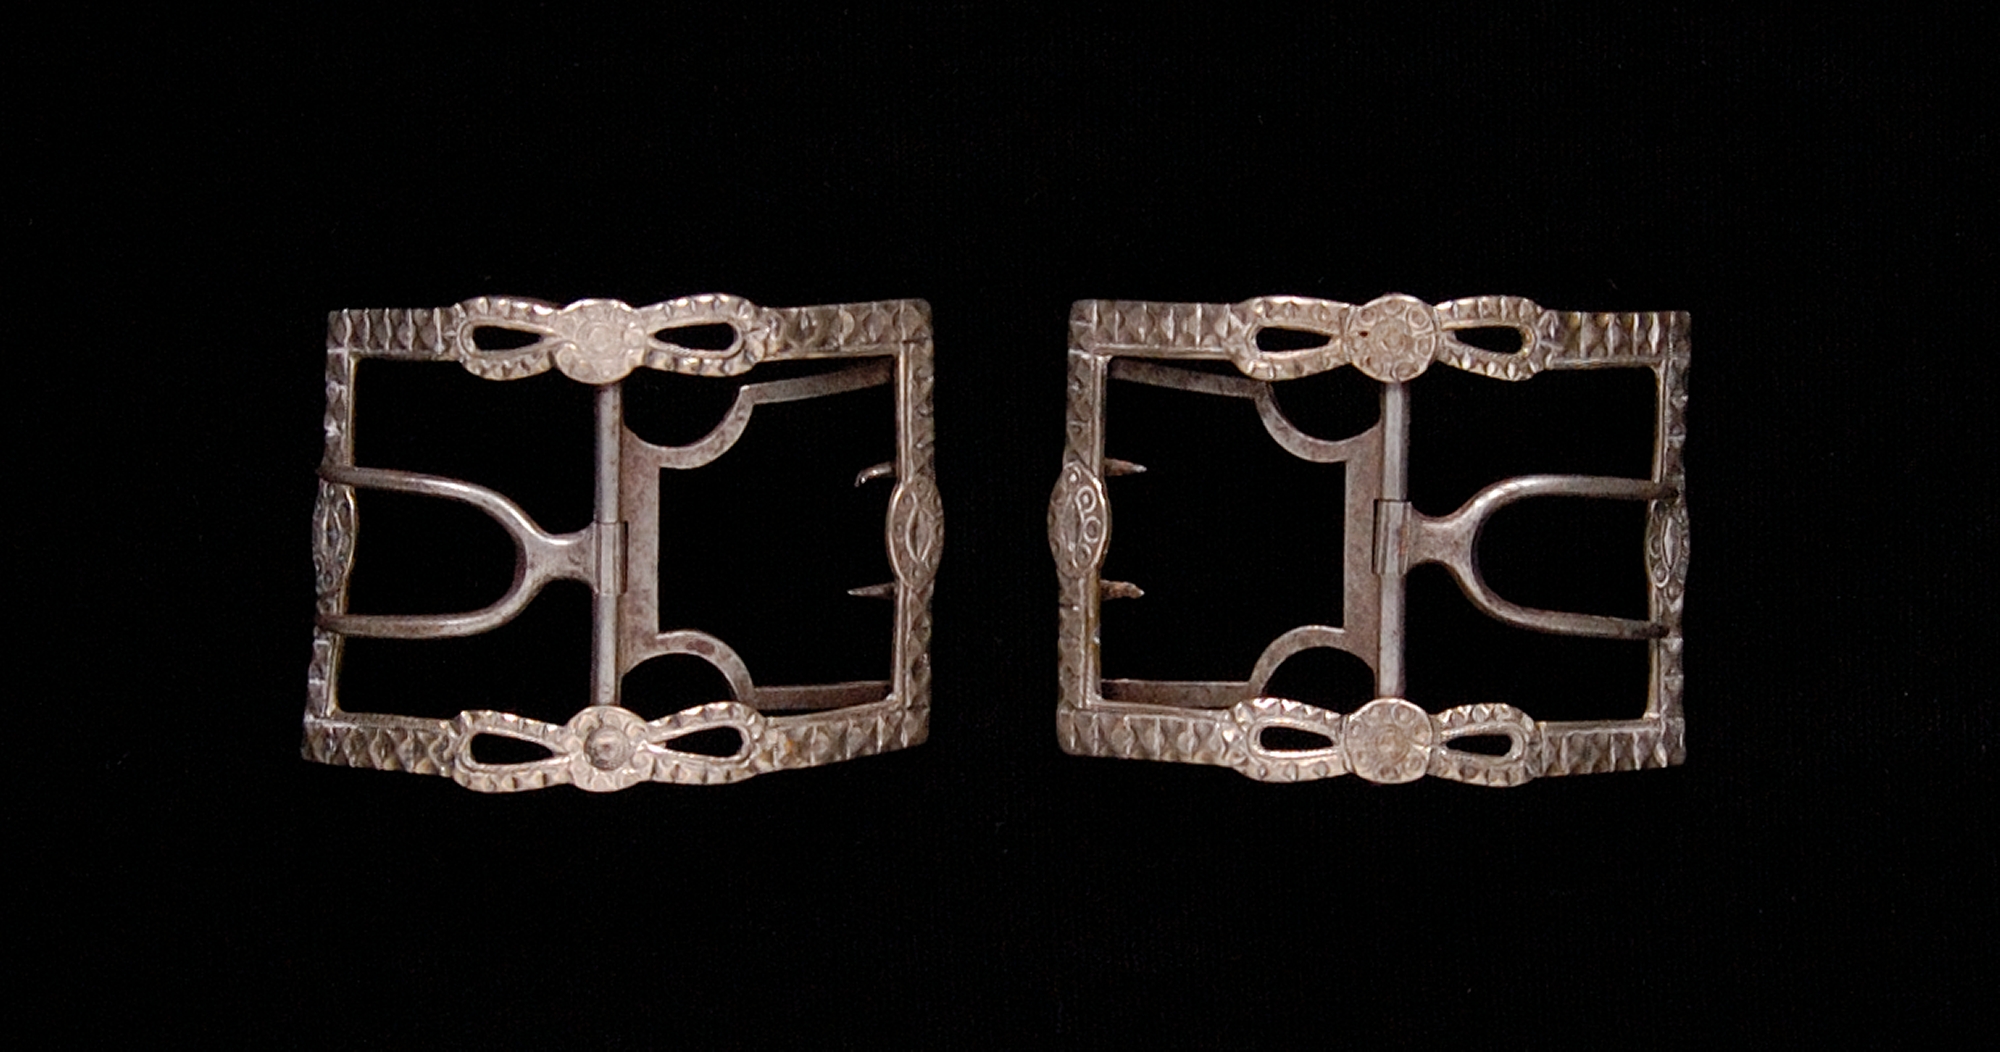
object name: shoe buckle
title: Shoe buckles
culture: british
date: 1770-1790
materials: metal